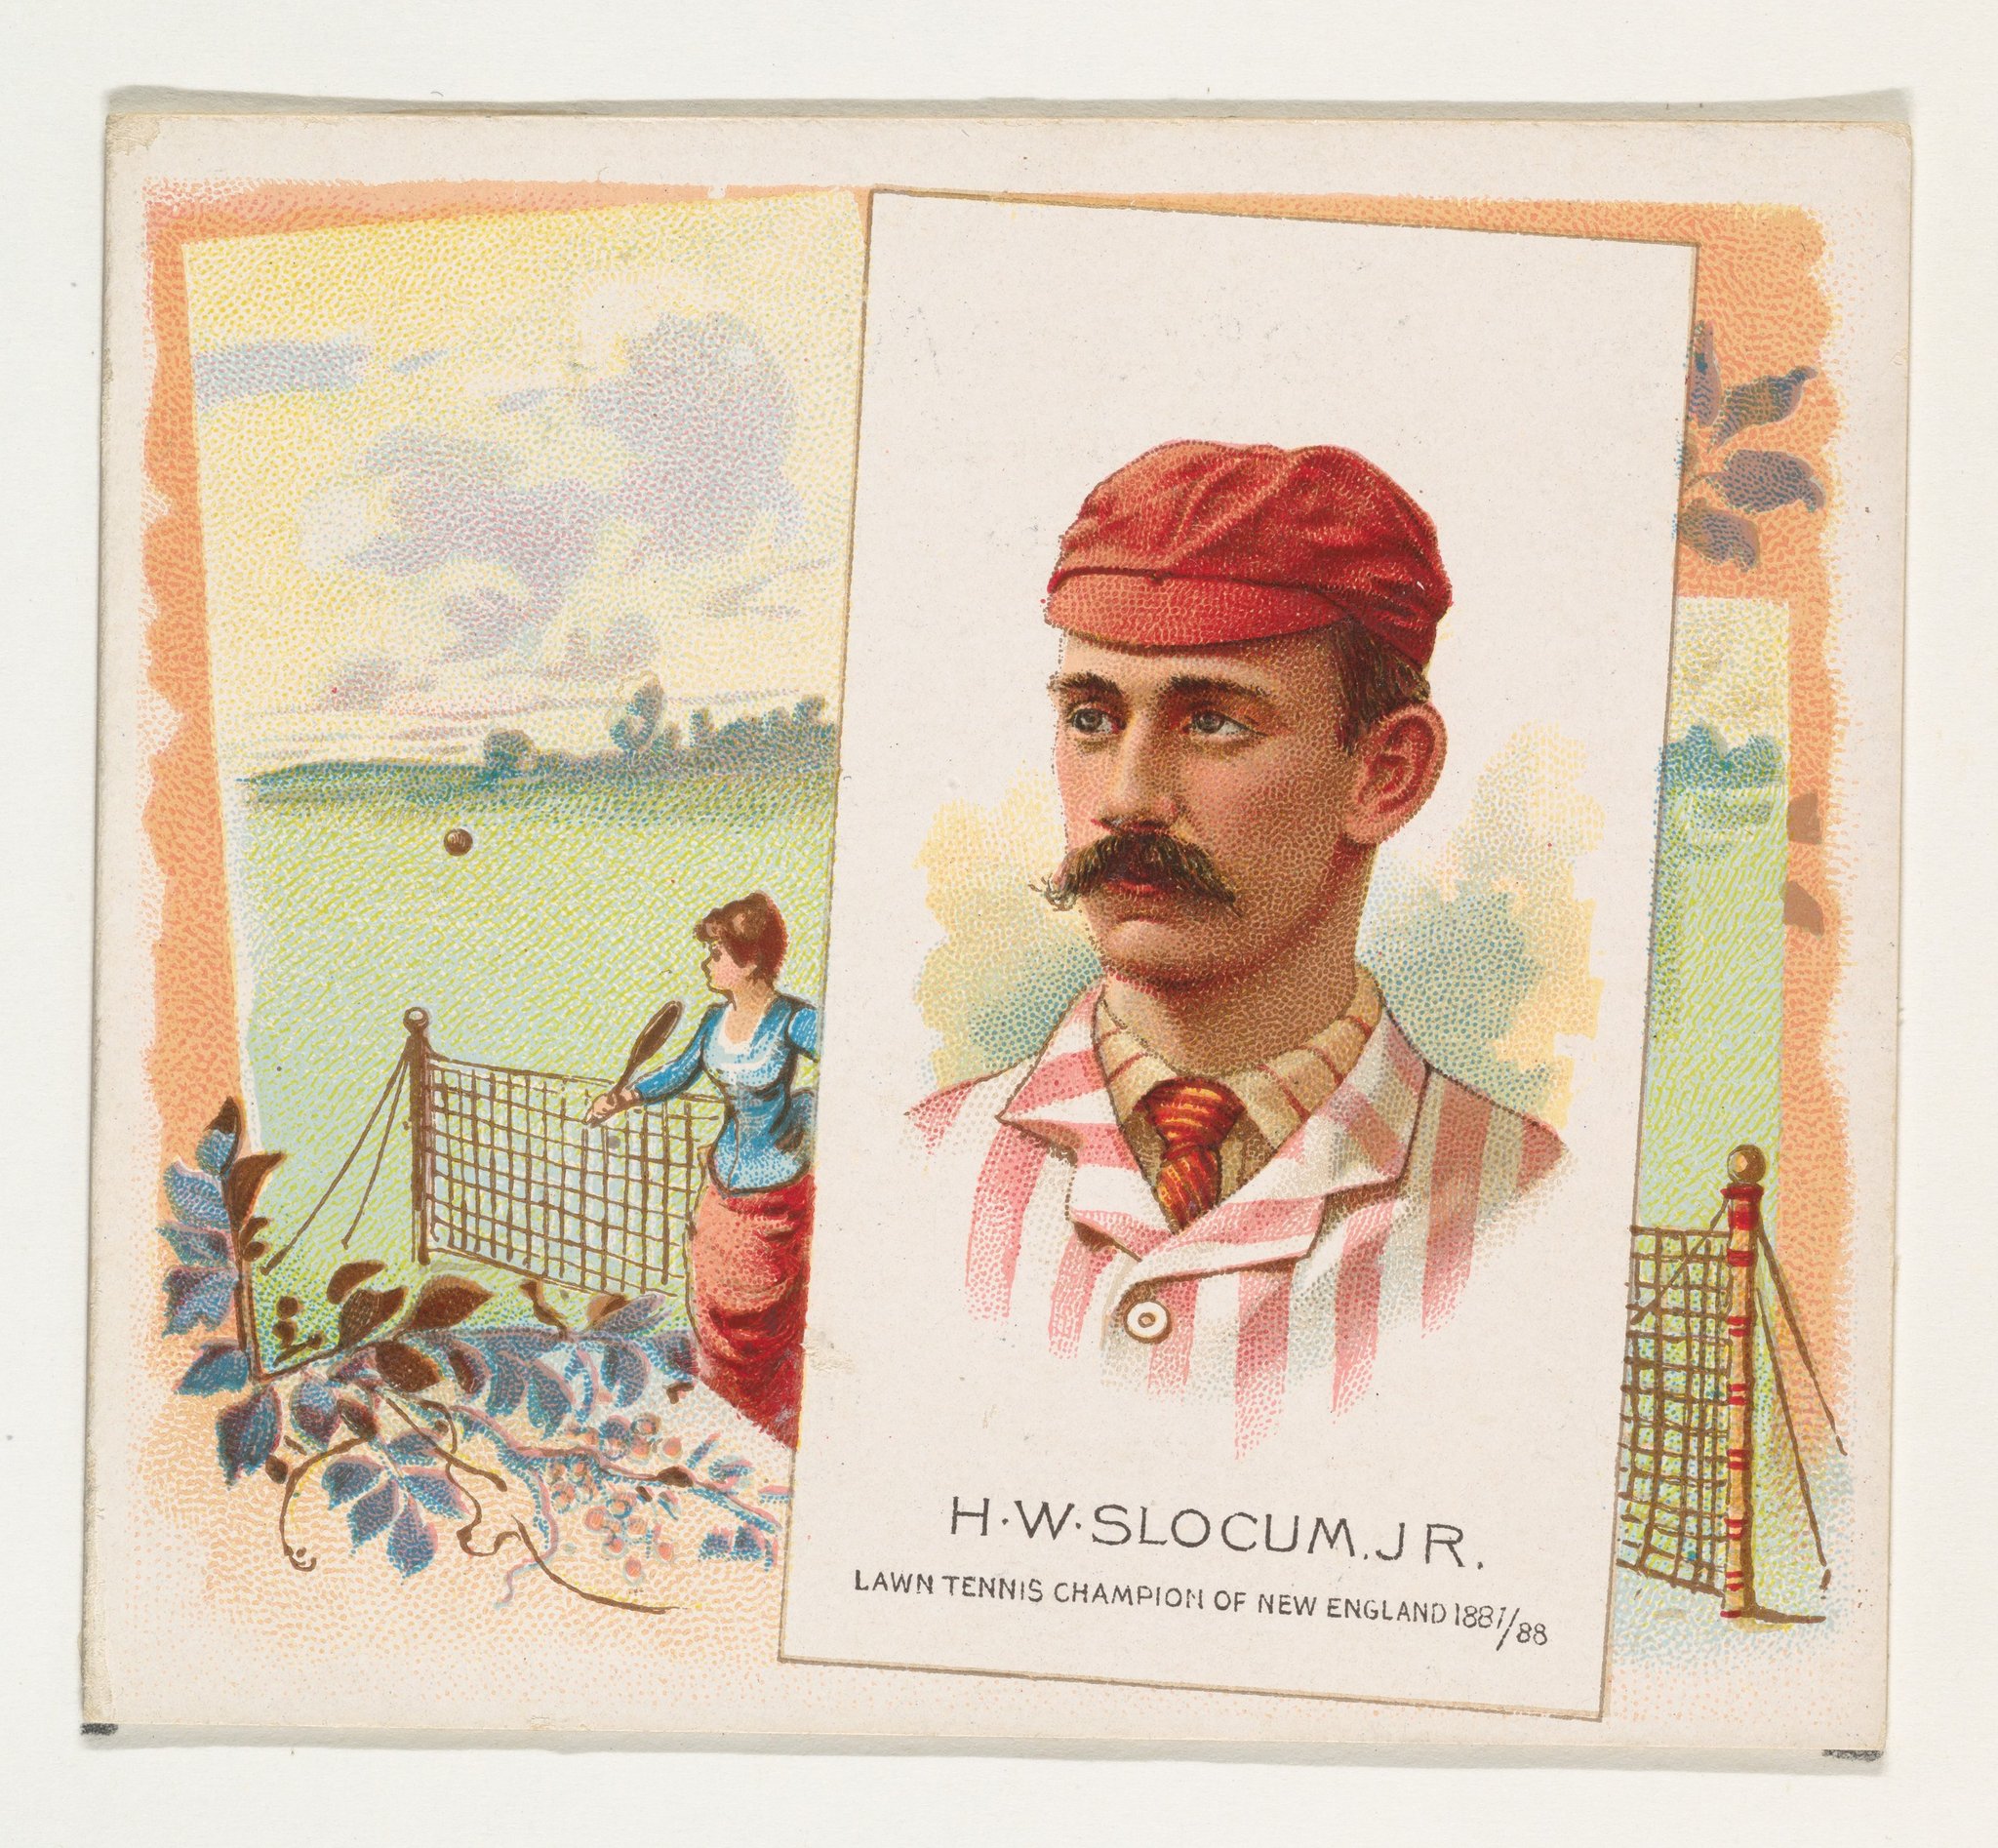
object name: print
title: H.W. Slocum, Jr., Lawn Tennis Champion of New England 1887/88, from World's Champions, Second Series (N43) for Allen & Ginter Cigarettes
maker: allen & ginter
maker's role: publisher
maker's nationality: american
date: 1888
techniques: lithography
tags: men,portraits,women,tennis